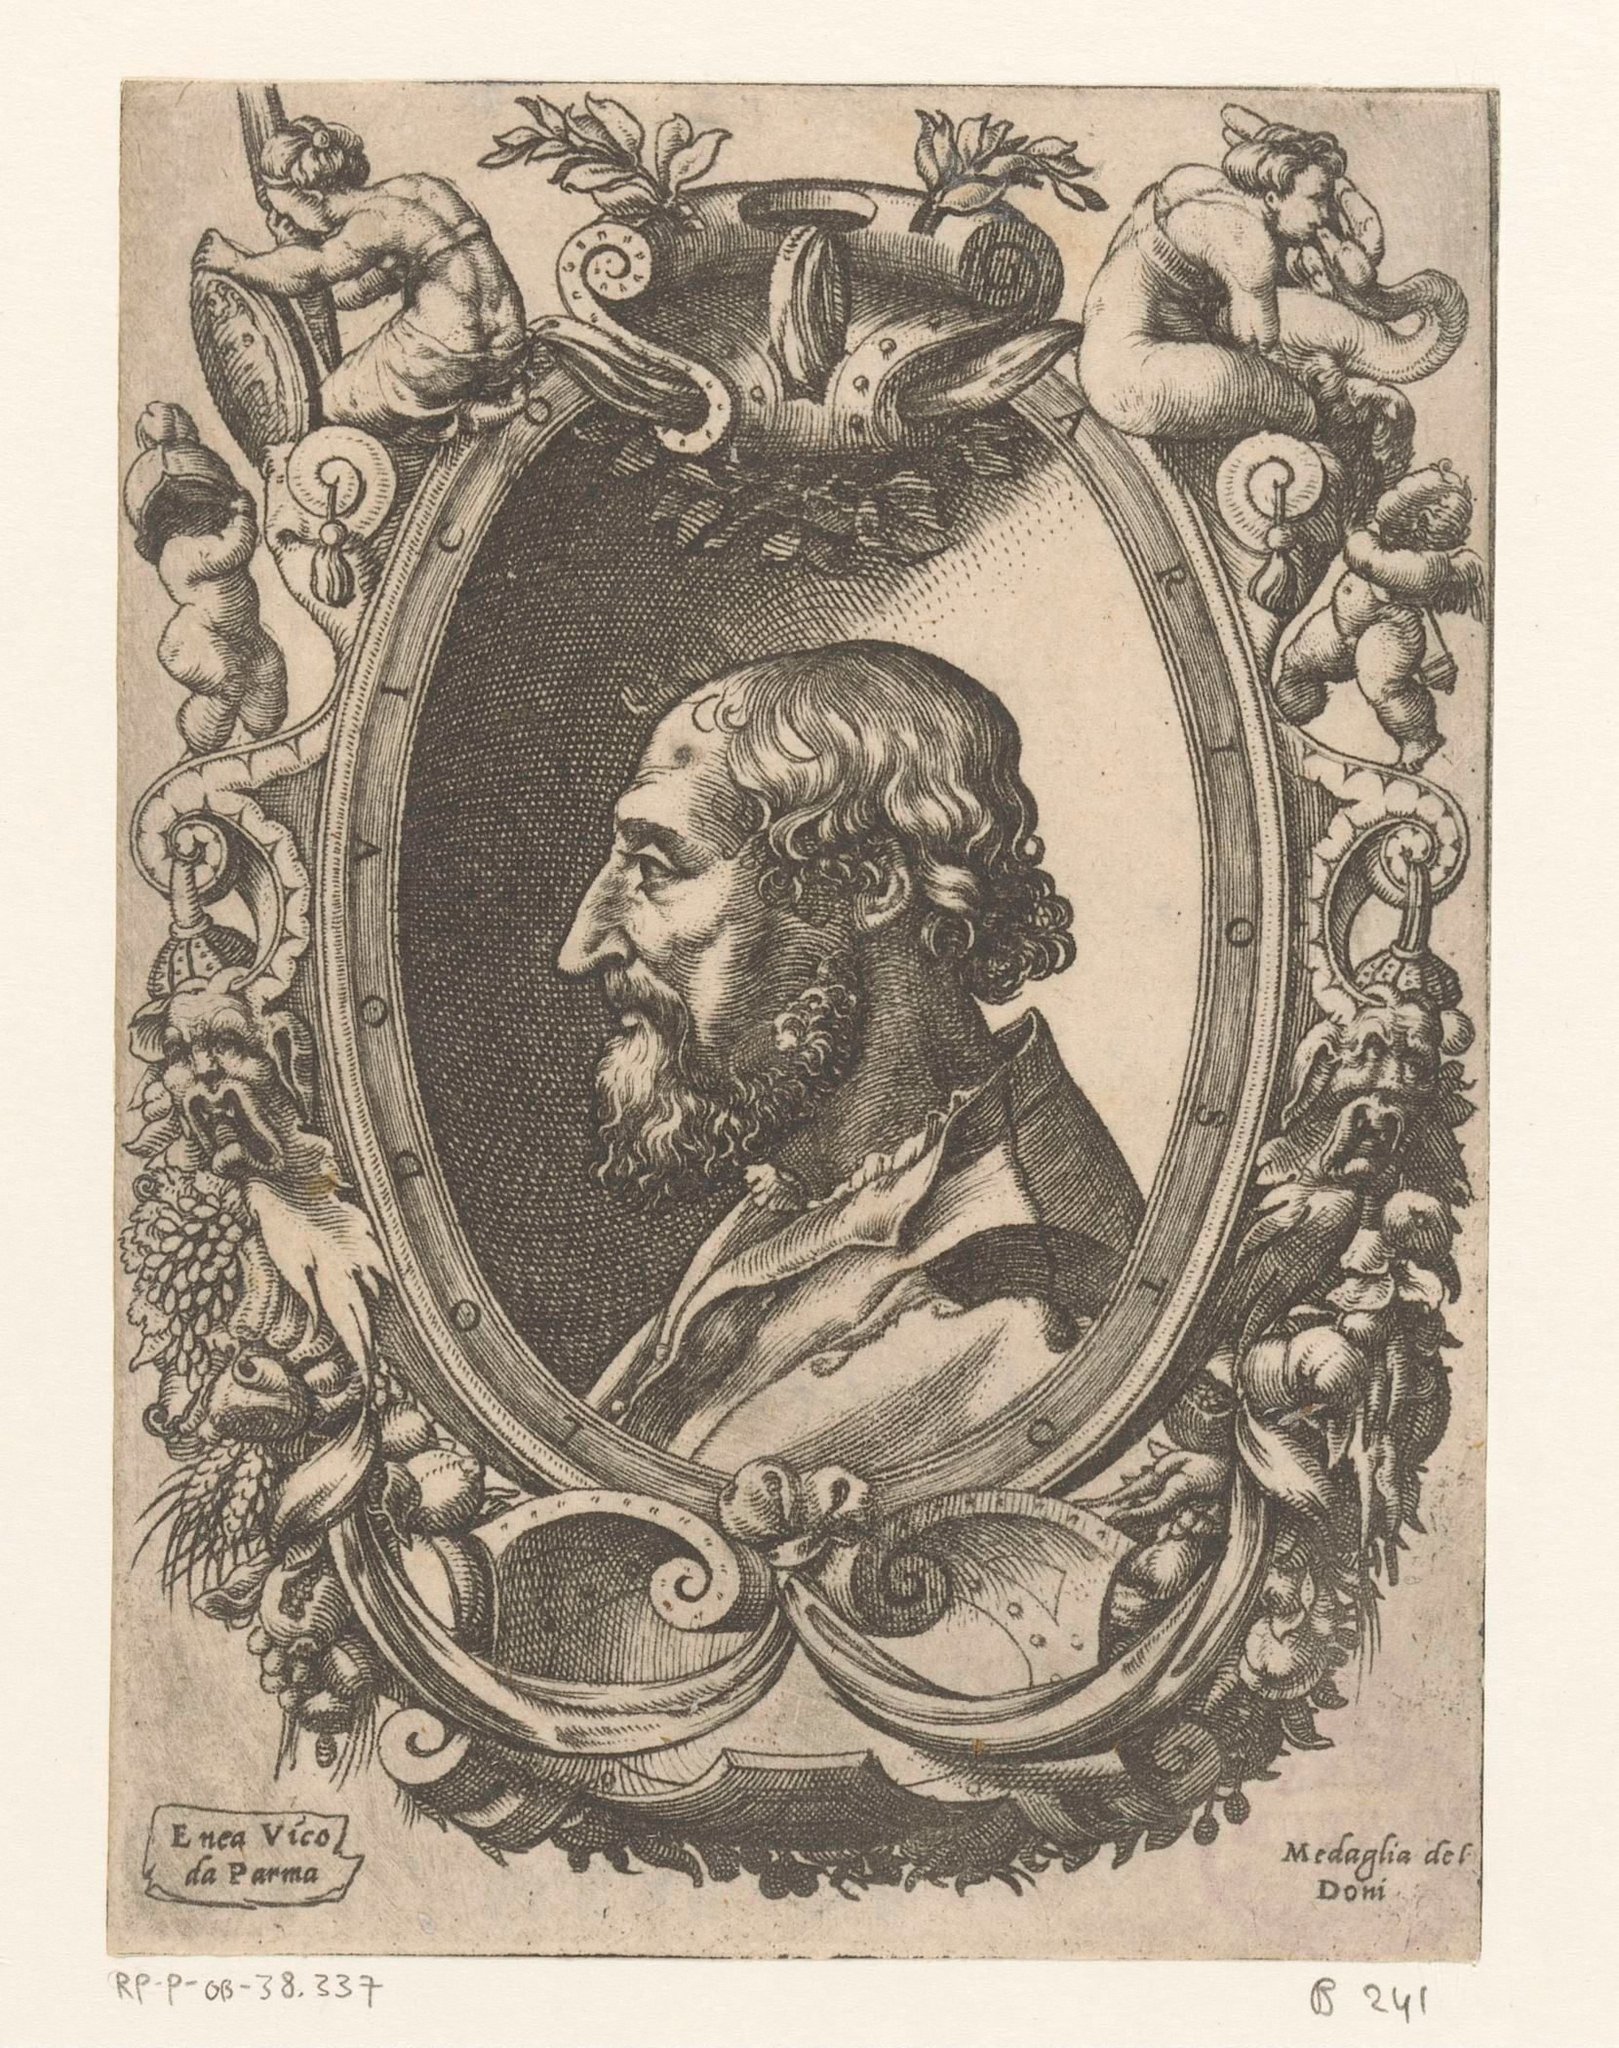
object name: print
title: Penningen van Anton Francesco Doni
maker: enea vico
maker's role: draughtsman, print maker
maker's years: 1523-1567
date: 1550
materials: paper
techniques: engraving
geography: italy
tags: ludovico ariosto, historical persons, writer, poet, author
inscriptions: collector's mark: Lugt 12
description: Portret van Ludovico Ariosto, gevat in een geornamenteerde lijst.